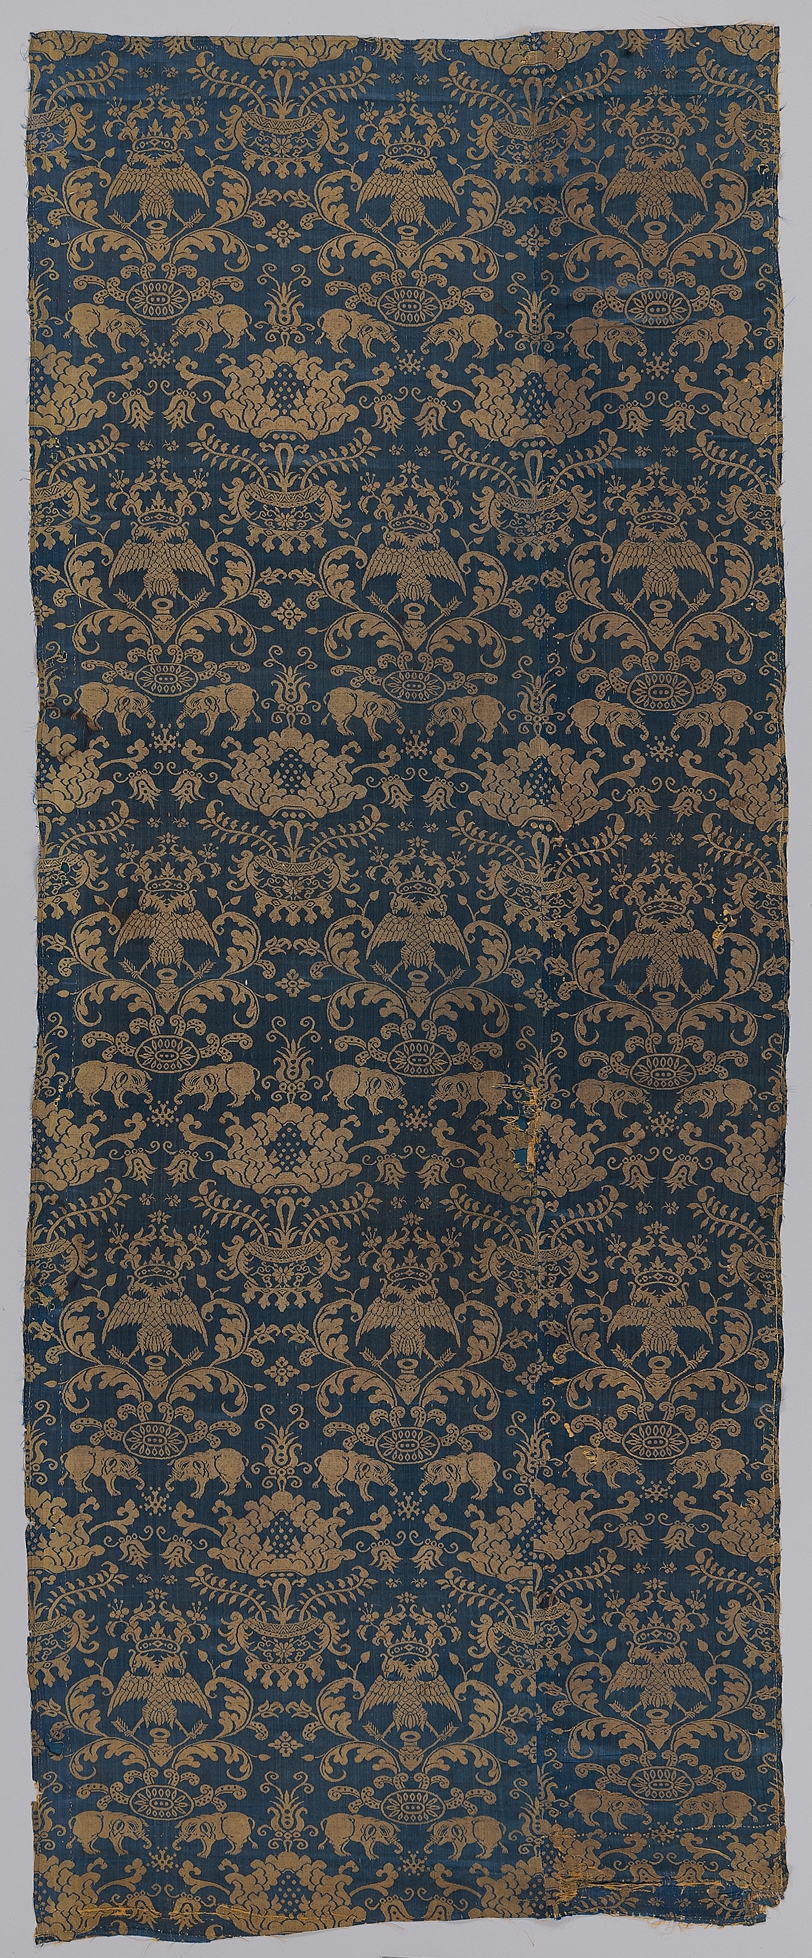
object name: piece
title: Textile with elephants, crowned double headed eagles, and flowers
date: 1551-1600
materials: silk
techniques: damask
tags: eagles,elephants,flowers